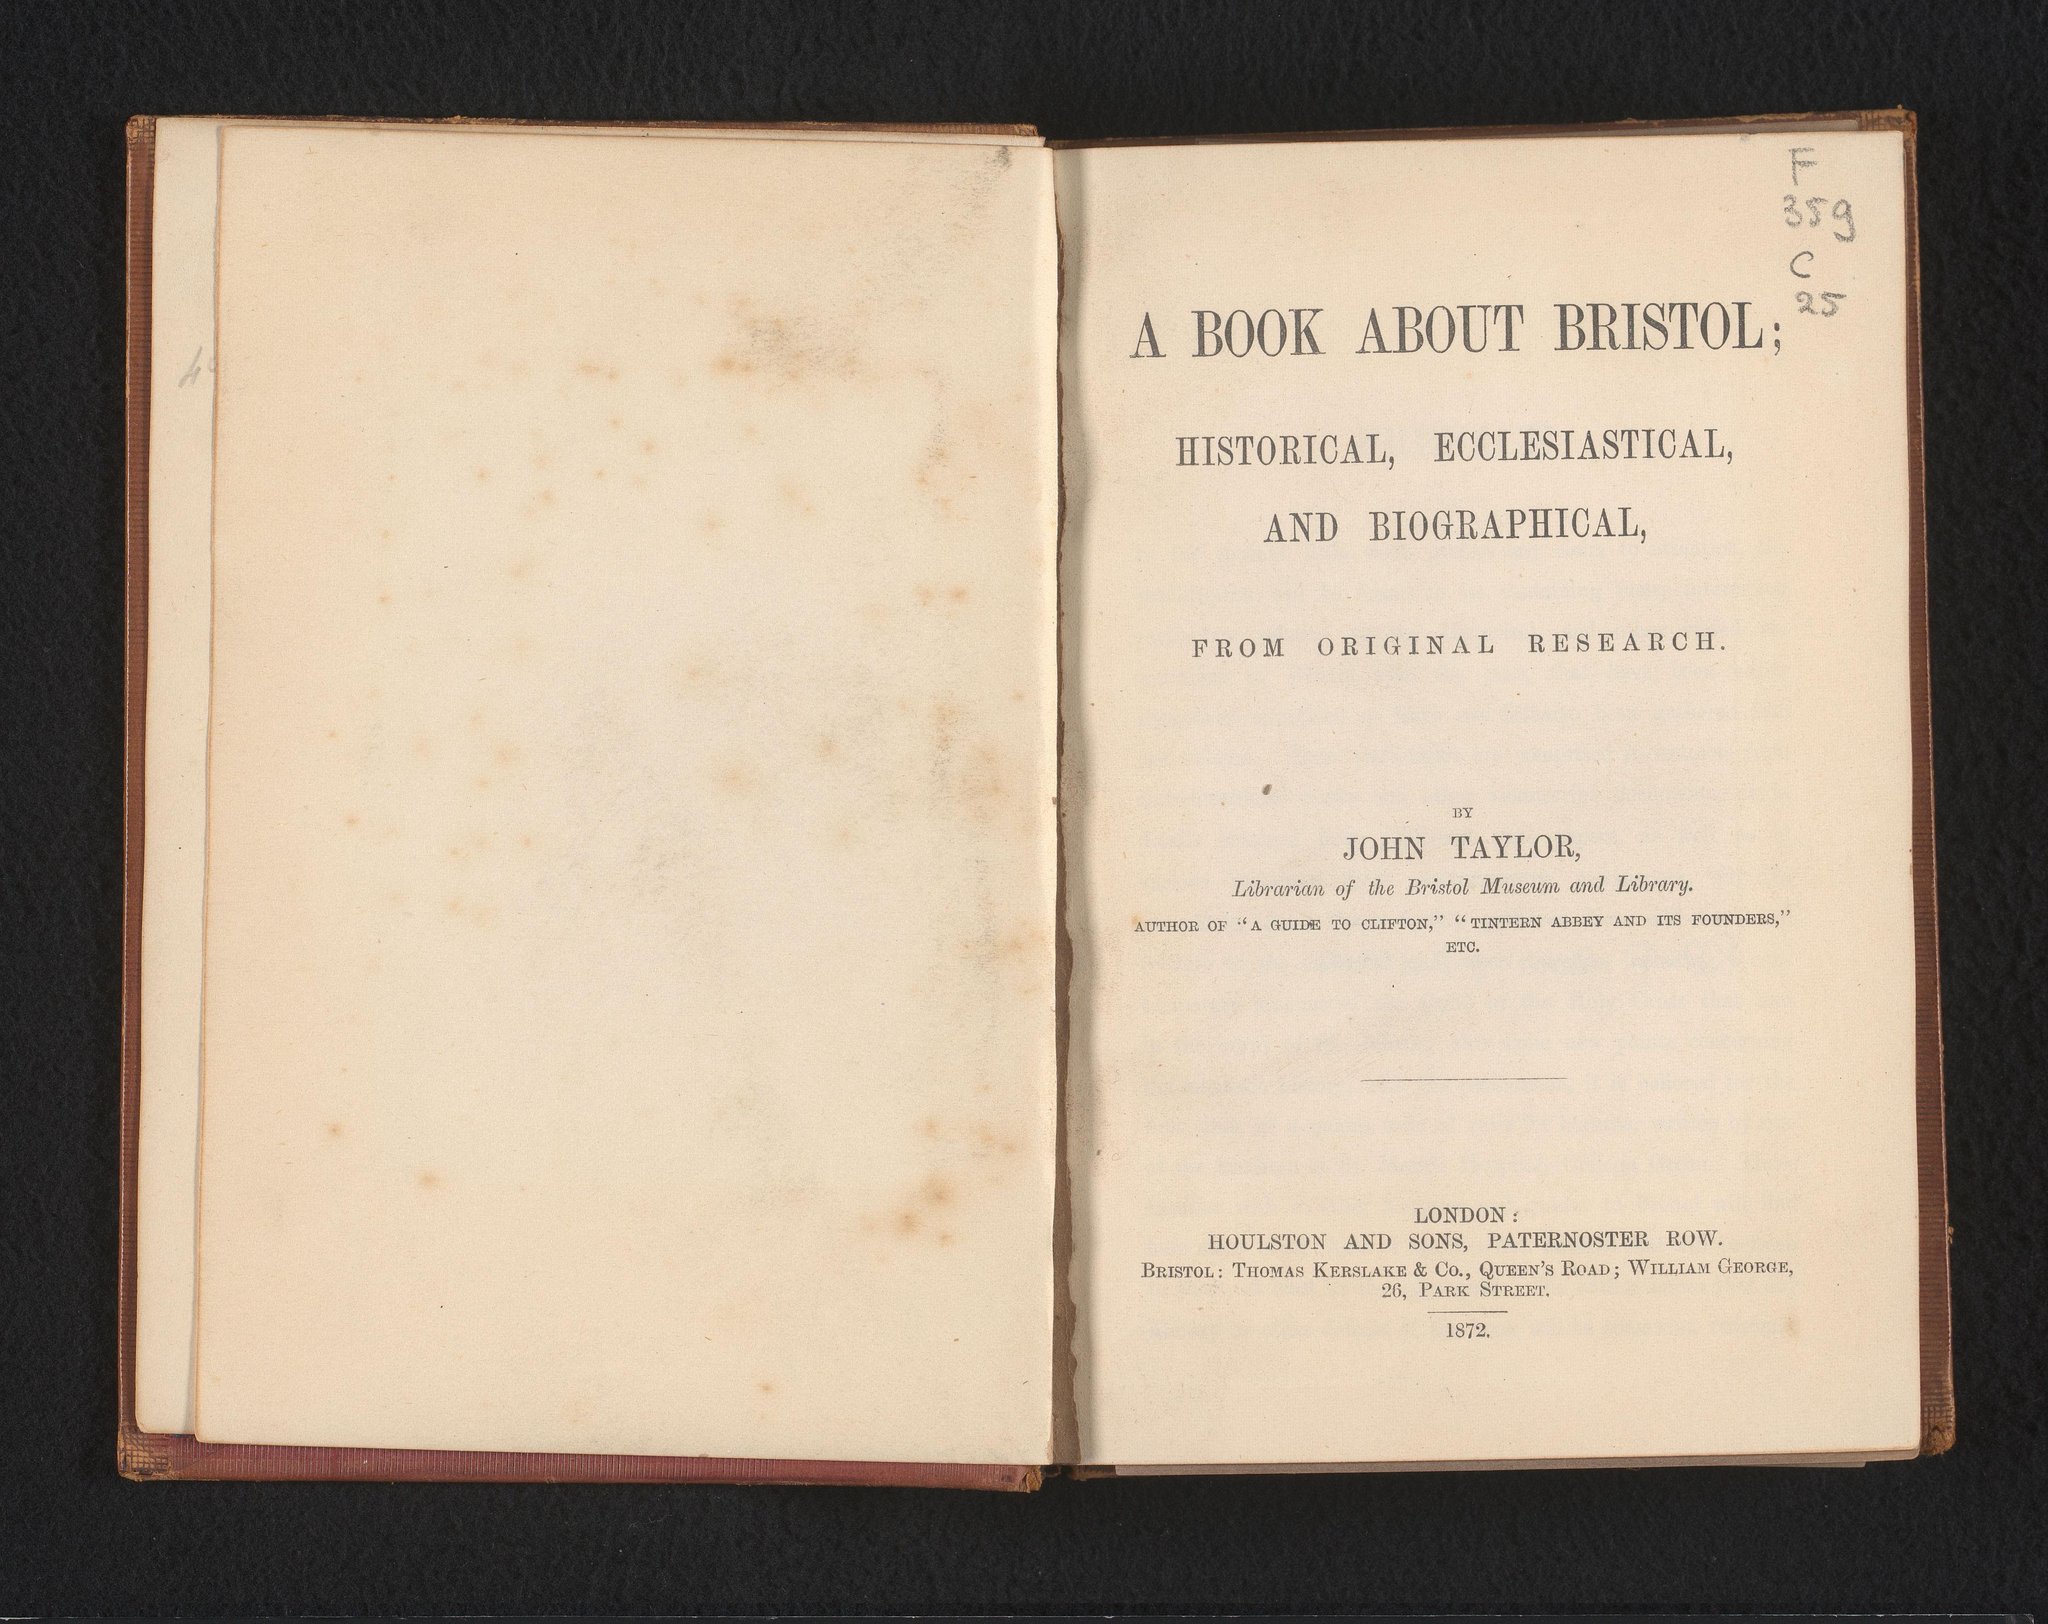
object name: book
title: A book about Bristol; historical, ecclesiastical, and biographical, from original research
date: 1872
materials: leather, cardboard, paper, textile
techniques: albumen print, marbled paper, marbling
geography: london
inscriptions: bookplate: ‘SFJ Oct 1981’, retailer's mark: ‘William George./ Antiquarian & Historical/ Bookseller,/ Top of Park Street, Bristol.’, inscription: ‘40 photographs/ In 18’, bookplate: ‘Optima Revelatio Stella/ Hugh J. Reveley’